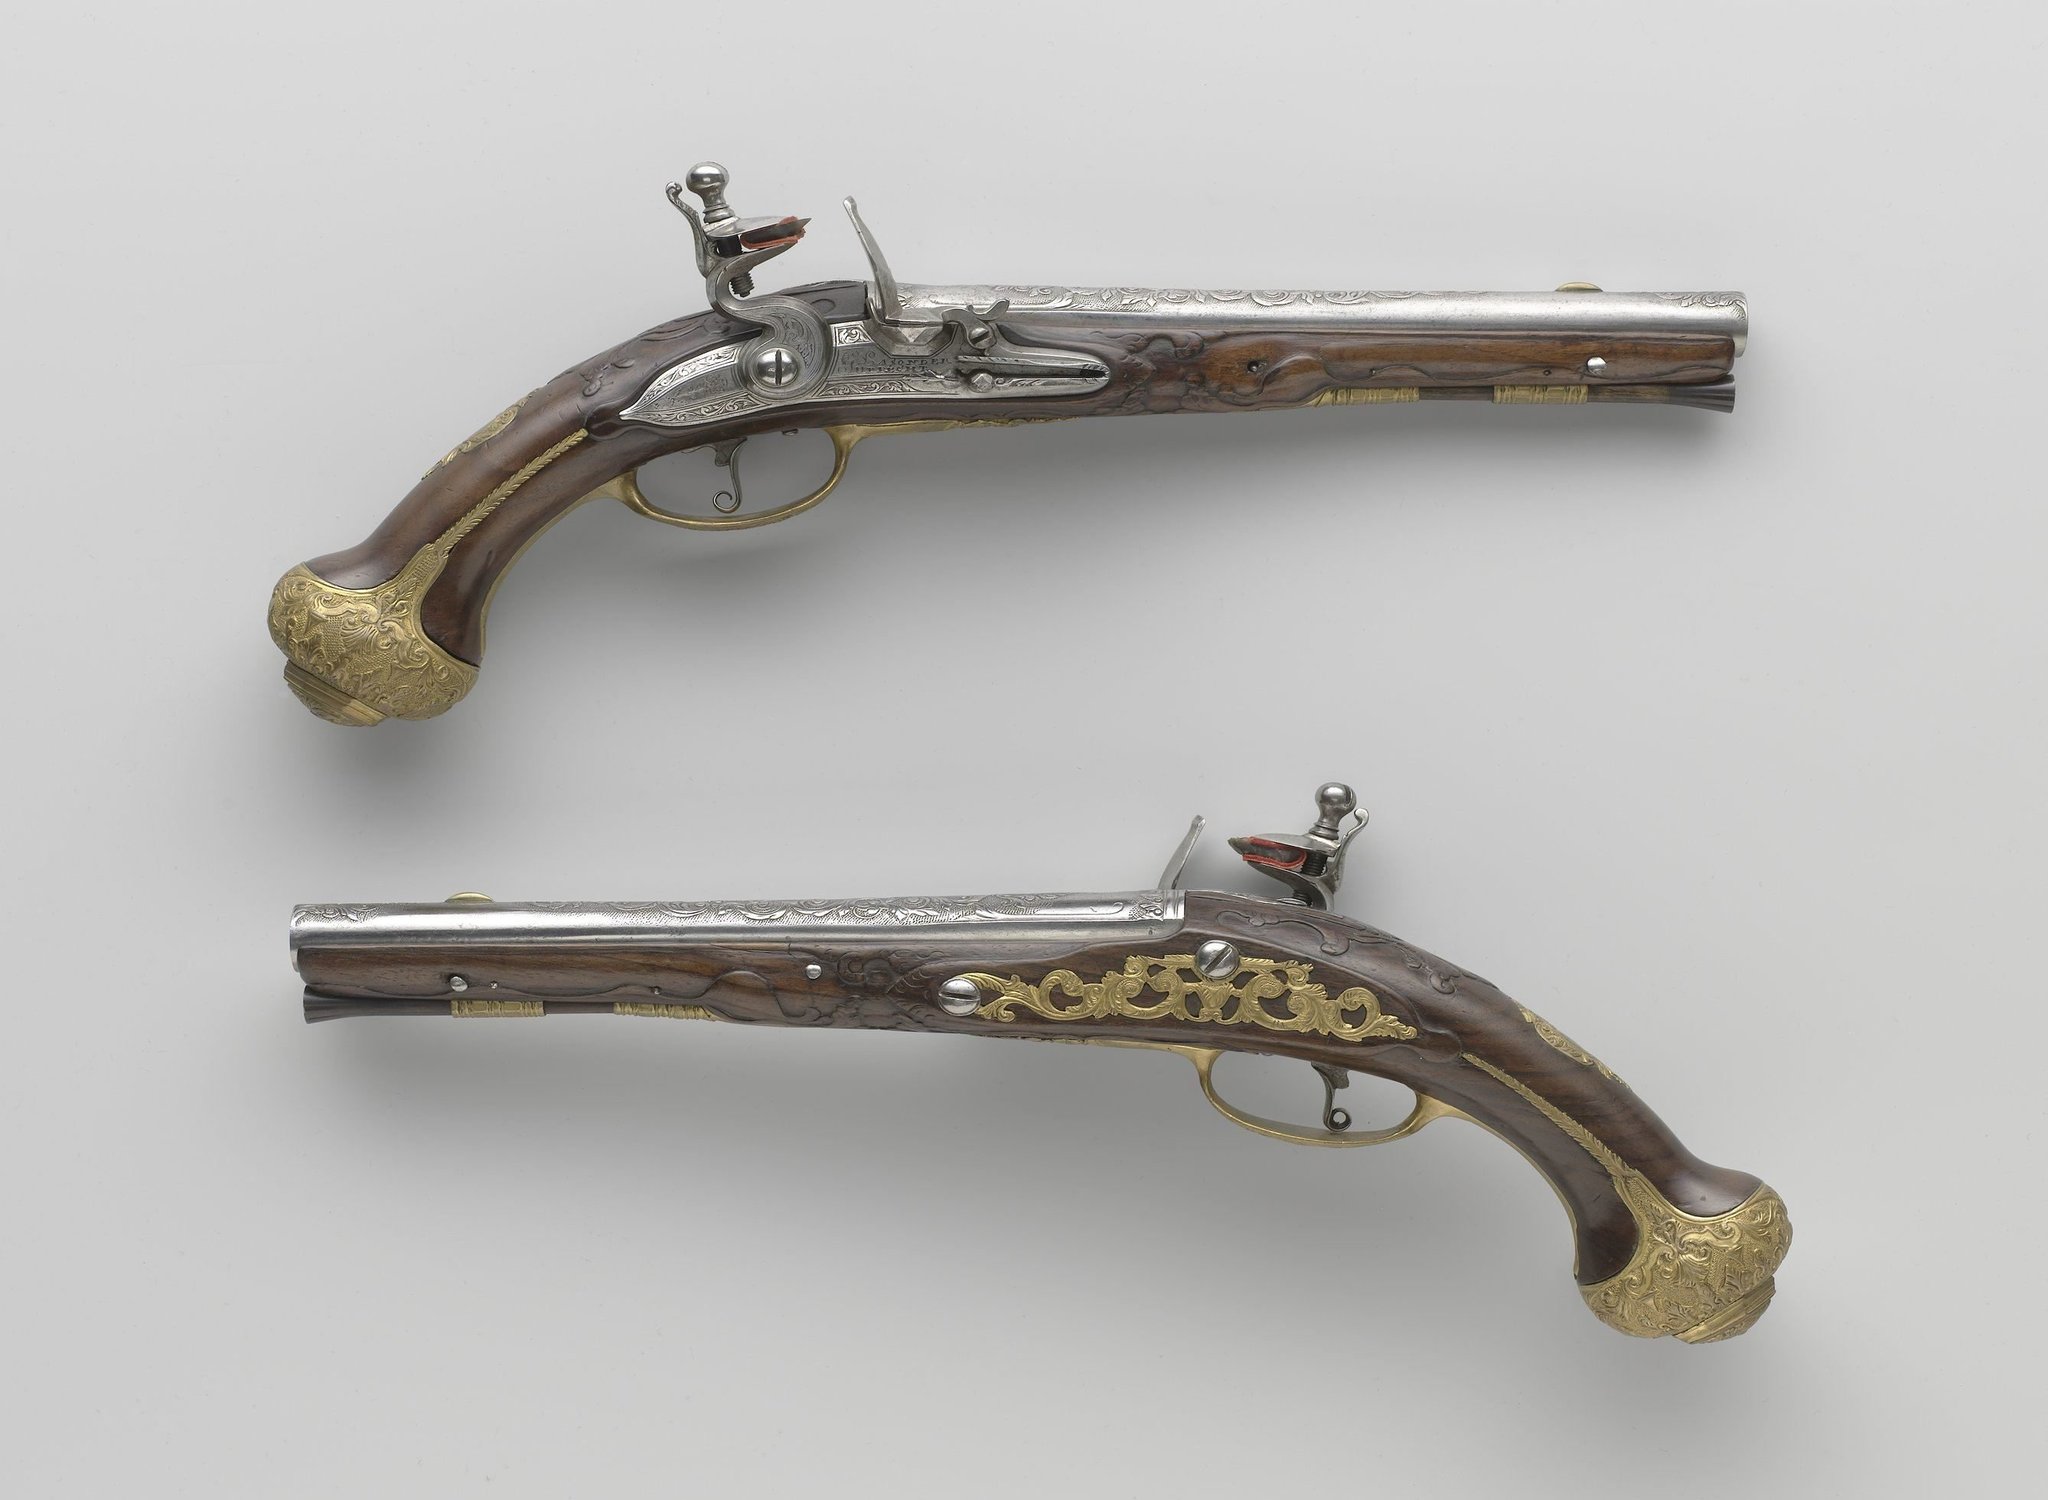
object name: flintlock pistol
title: Vuursteenpistool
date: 1720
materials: brass, horn, wood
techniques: printing, metalworking, cutting, embroidery, engraving, gilding, granulation, relief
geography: utrecht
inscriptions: coat of arms, inscription: ‘G.LASONDER // UTRECHT’, mark: ‘LM’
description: Tentoongesteld in: Stedelijk Museum De Lakenhal, Leiden, juli-sept 1978.